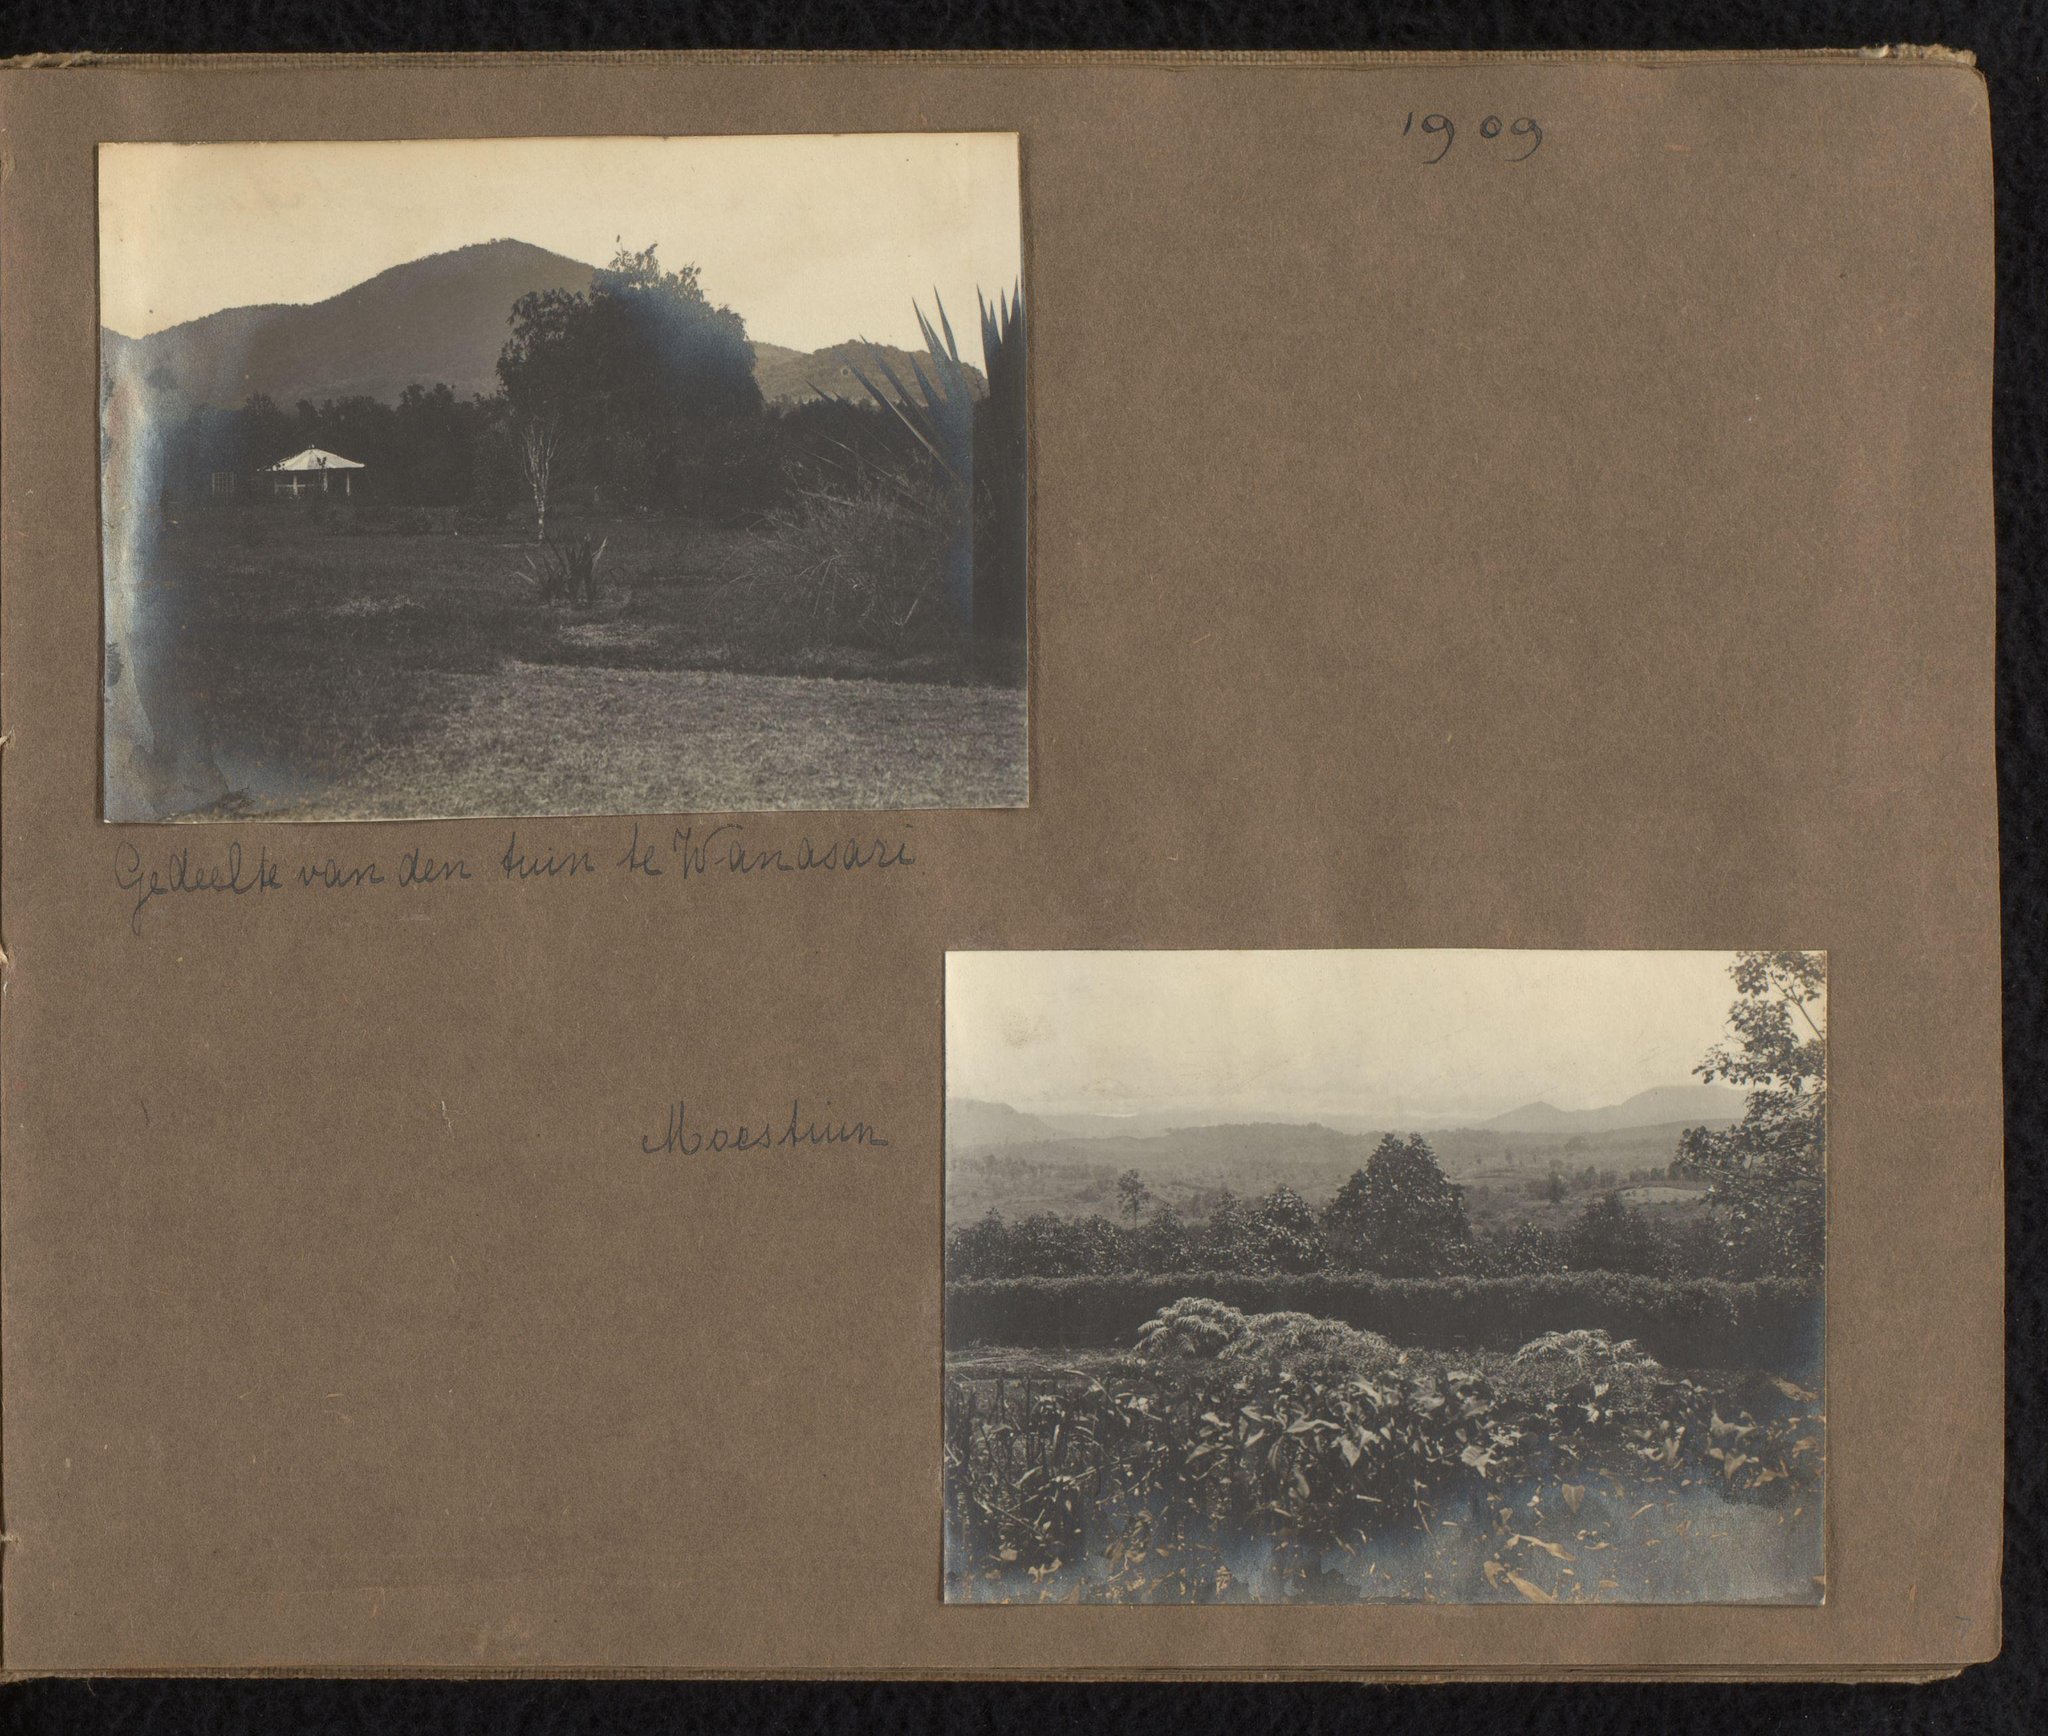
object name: photograph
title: Twee foto's van een tuin en moestuin in Wanasari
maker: carolina frederika onnen (lien/loen)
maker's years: 1896-1983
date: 1909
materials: paper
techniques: gelatin silver print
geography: wanasari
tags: garden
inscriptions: inscription: ‘Moestuin’, inscription: ‘Gedeelte van den tuin te Wanasari’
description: Deze foto's maken deel uit van een album.